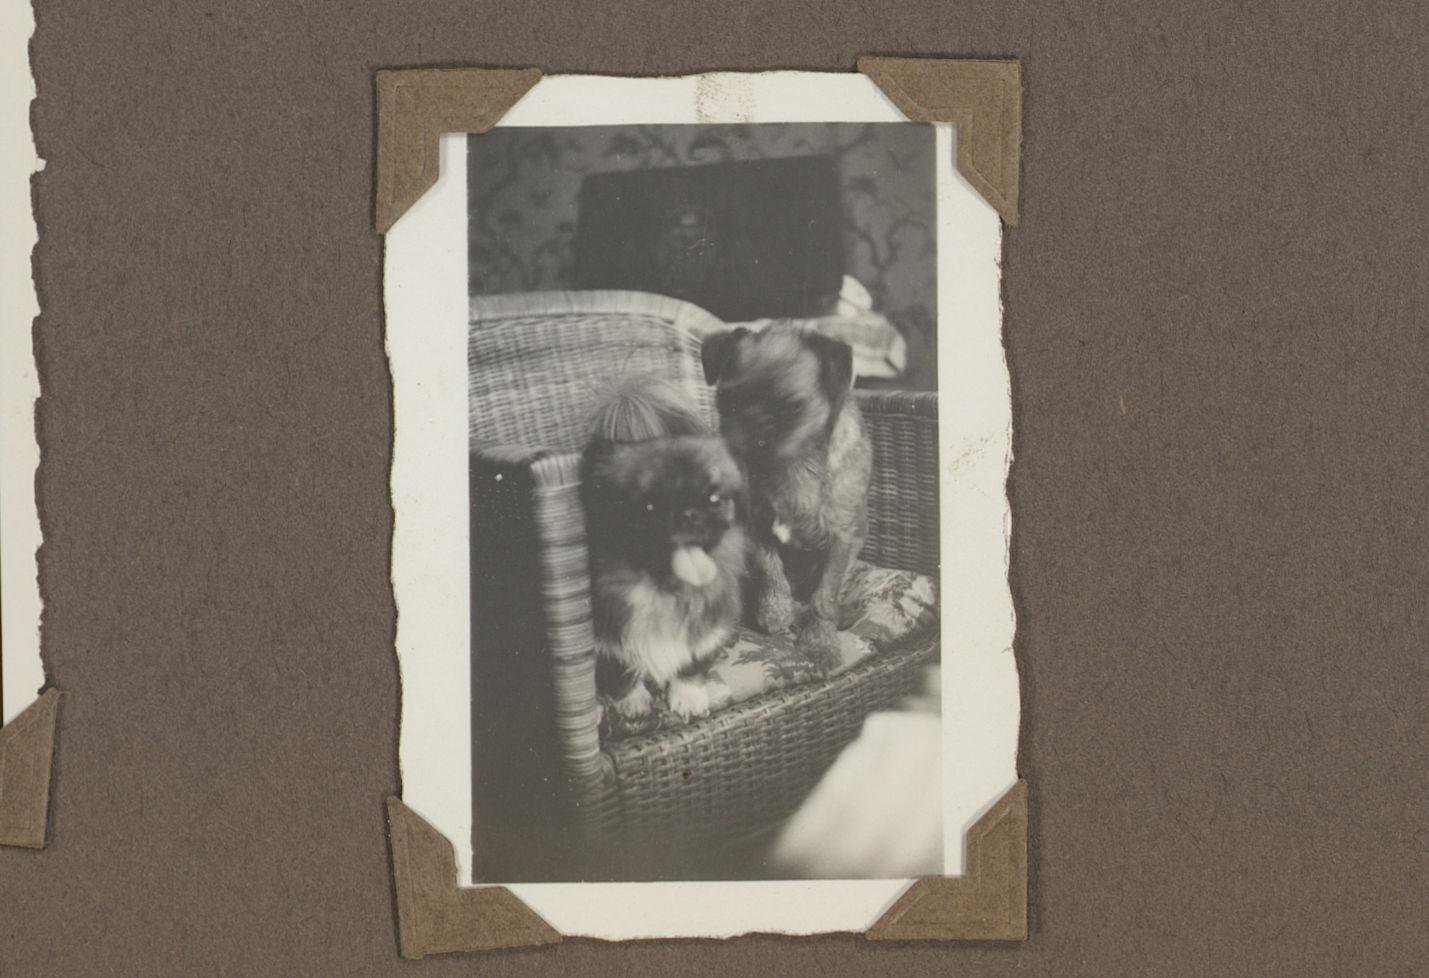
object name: album leaf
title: Twee honden op een stoel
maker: Anonymous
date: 1930-1935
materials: paper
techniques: gelatin silver print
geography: netherlands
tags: dog, netherlands